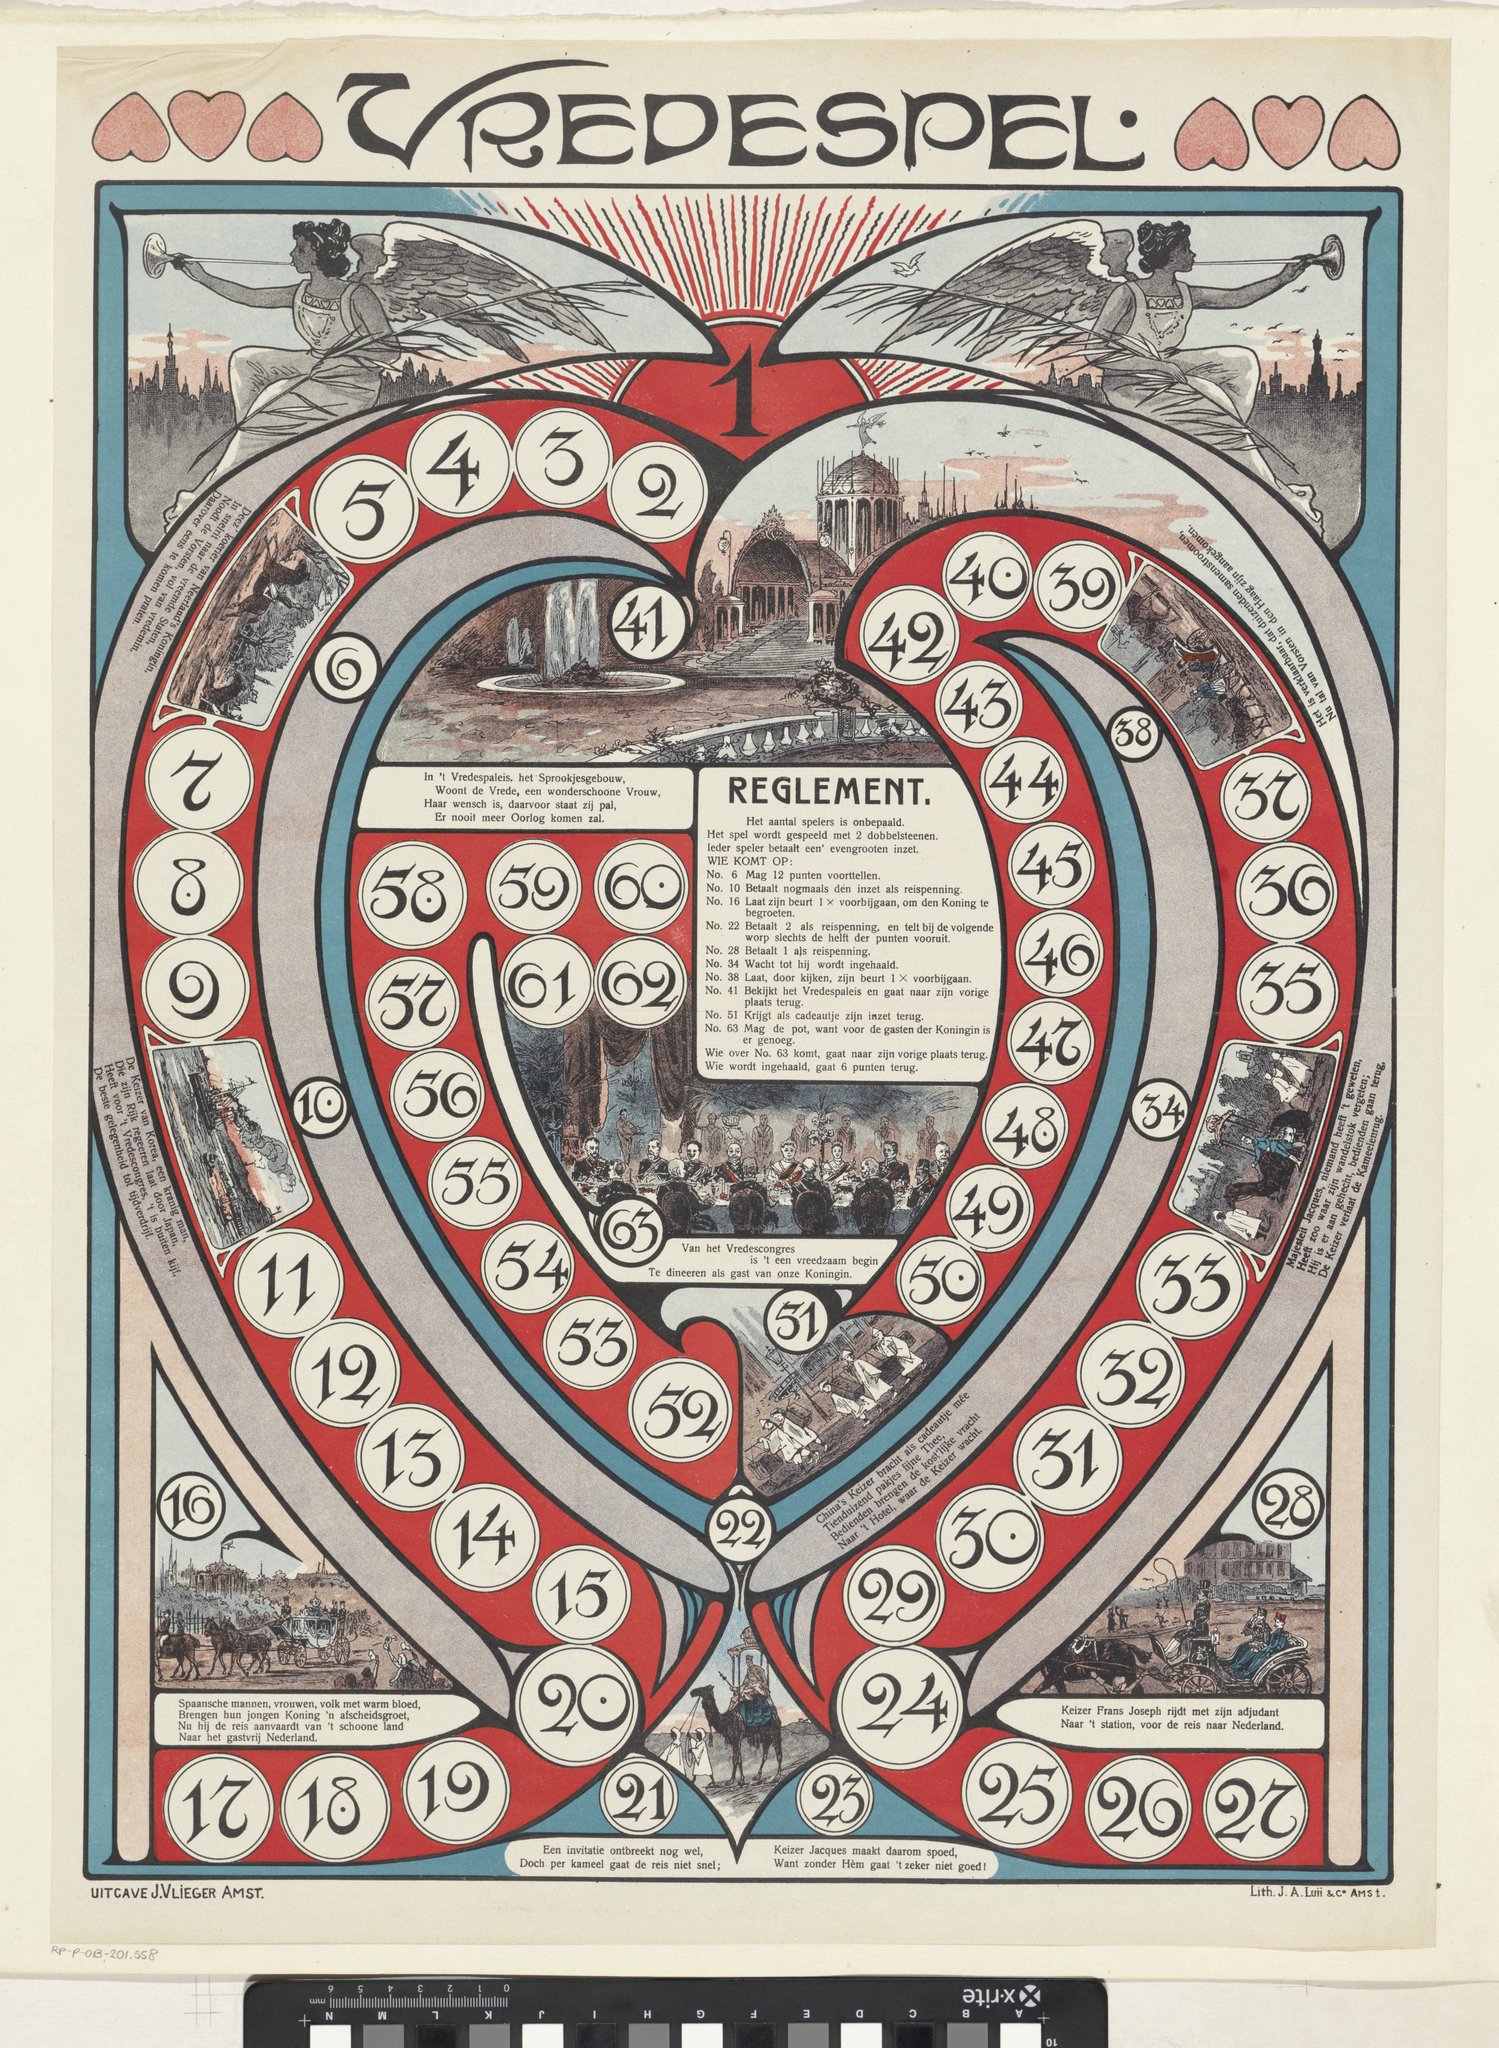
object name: print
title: Vredespel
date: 1907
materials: paper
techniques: lithograph, letterpress printing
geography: amsterdam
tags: board-games of chance, angels singing, making music, board-games, peace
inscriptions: collector's mark: Lugt 2760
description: Bordspel ter gelegenheid van de tweede Vredesconferentie in Den Haag in 1907 en het begin van de bouw van het Vredespaleis. Hartvormig ganzenbordachtig spel met vakjes genummerd van 1 tot en met 63. Op het middenveld de spelregels in boekdruk. Boven twee bazuinblazende vredesengelen; verder afbeeldingen van de reis van de diverse staatshoofden en een fantasievoorstelling van het nog te bouwen Vredespaleis.